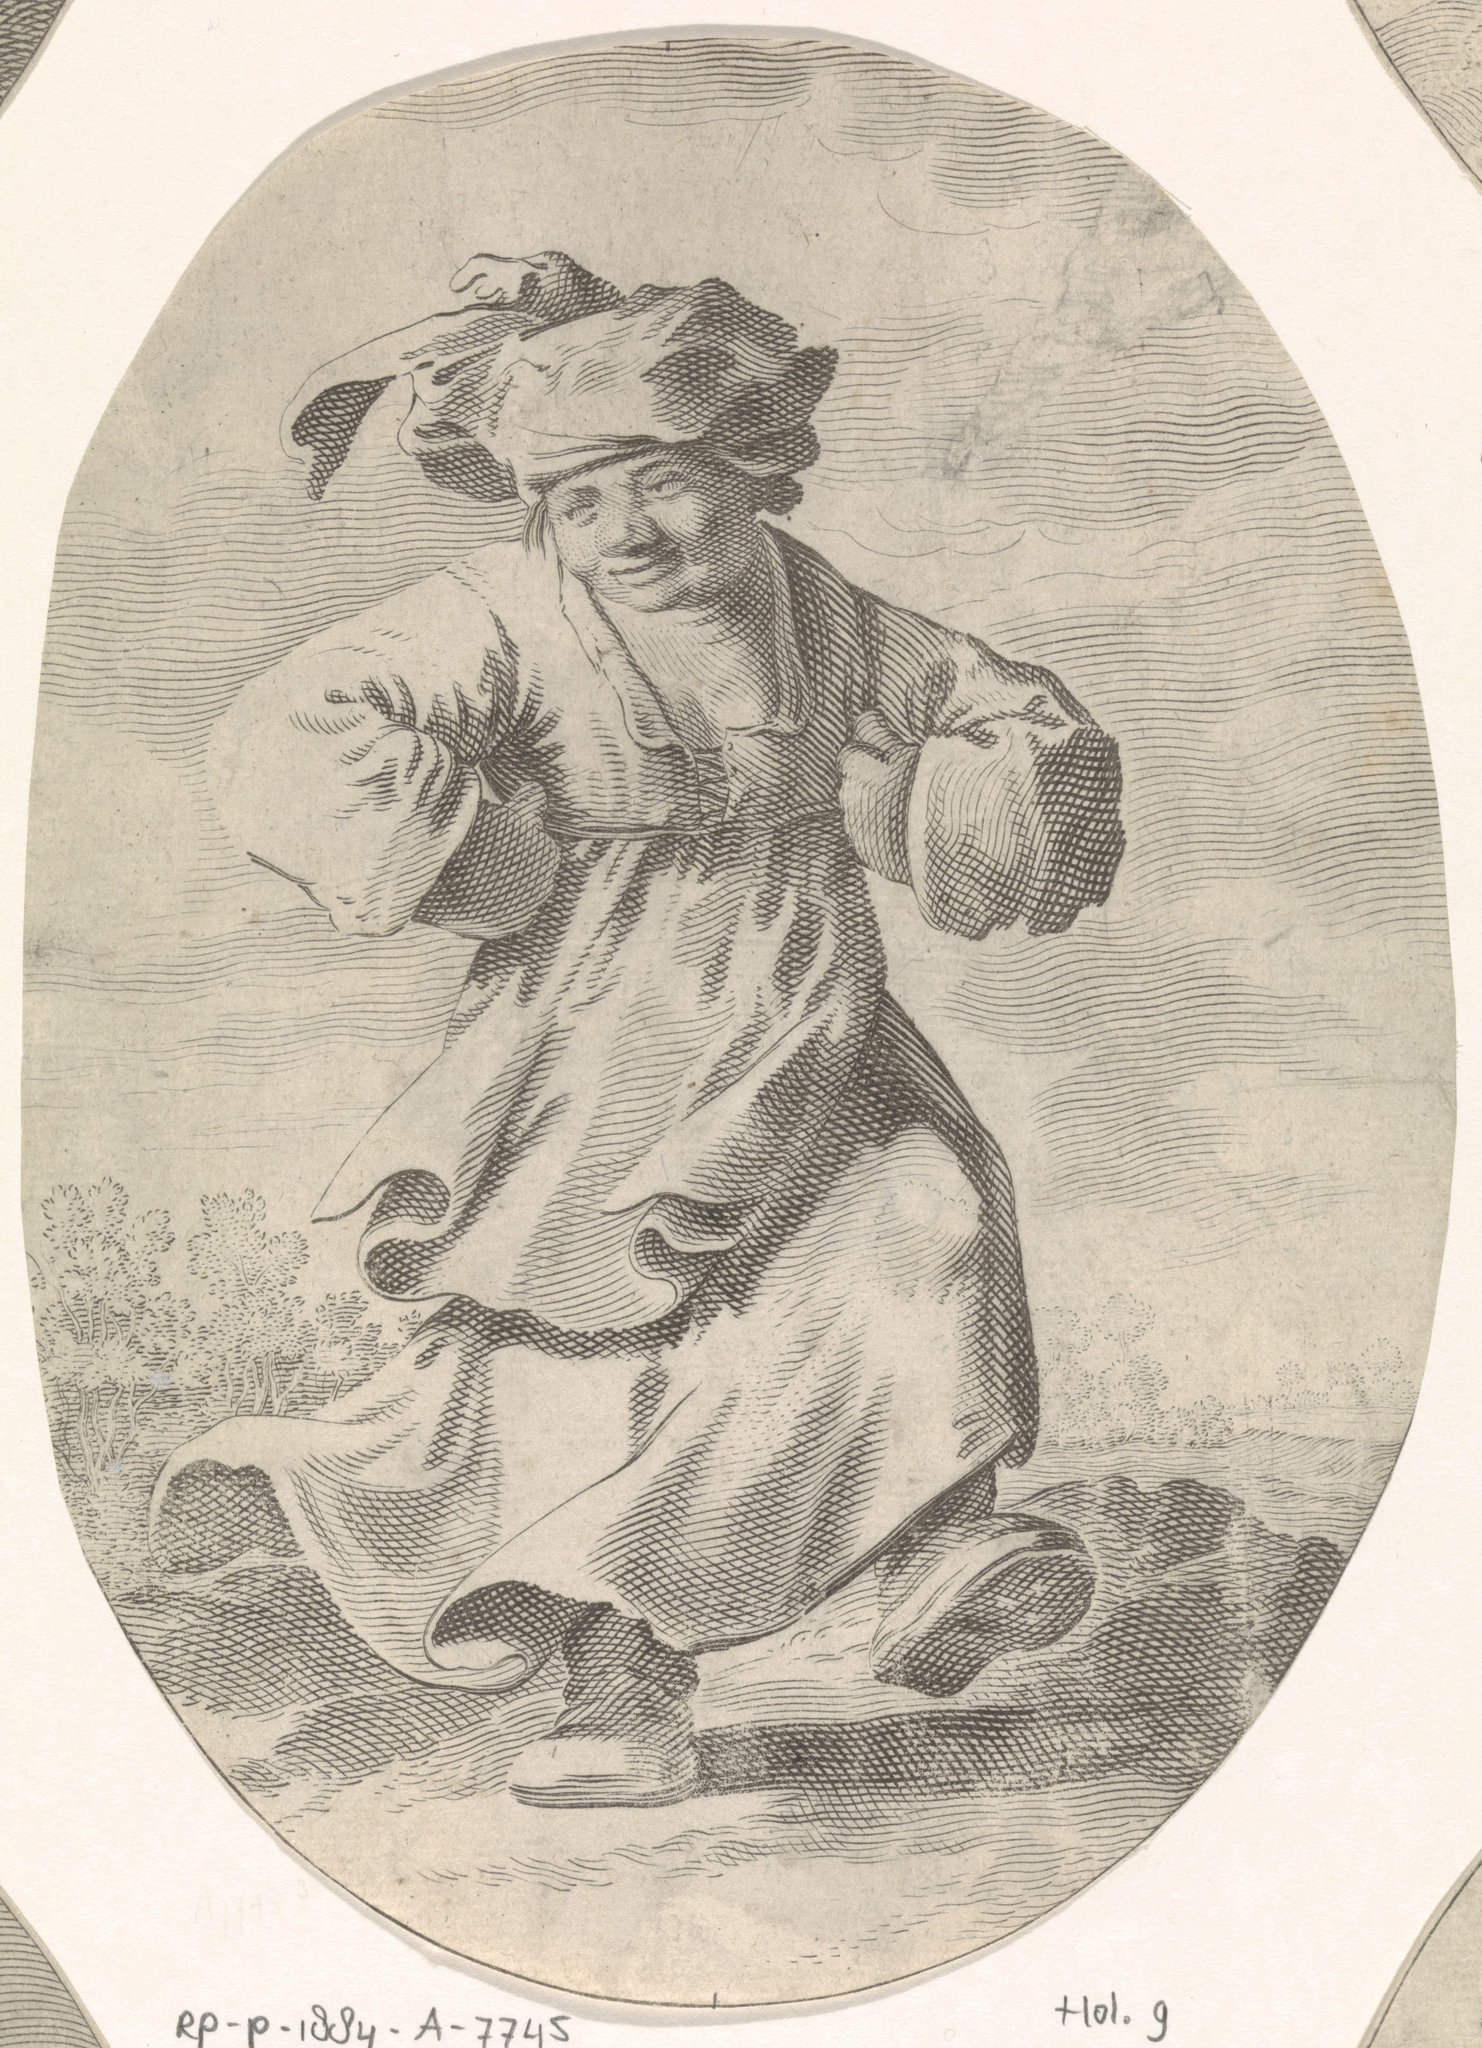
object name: print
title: Boeren en boerinnen in obscene houdingen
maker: nicolaes van lijnhoven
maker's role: draughtsman, print maker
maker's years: -1702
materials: paper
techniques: engraving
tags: scabrous scenes, pornography (+ variant), gesture-language, farmers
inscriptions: collector's mark: Lugt 2228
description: Een dansende boerin in een landschap, met de handen in de zij. De prent maakt deel uit van een zesdelige serie prenten met voorstellingen van boeren en boerinnen in obscene houdingen.